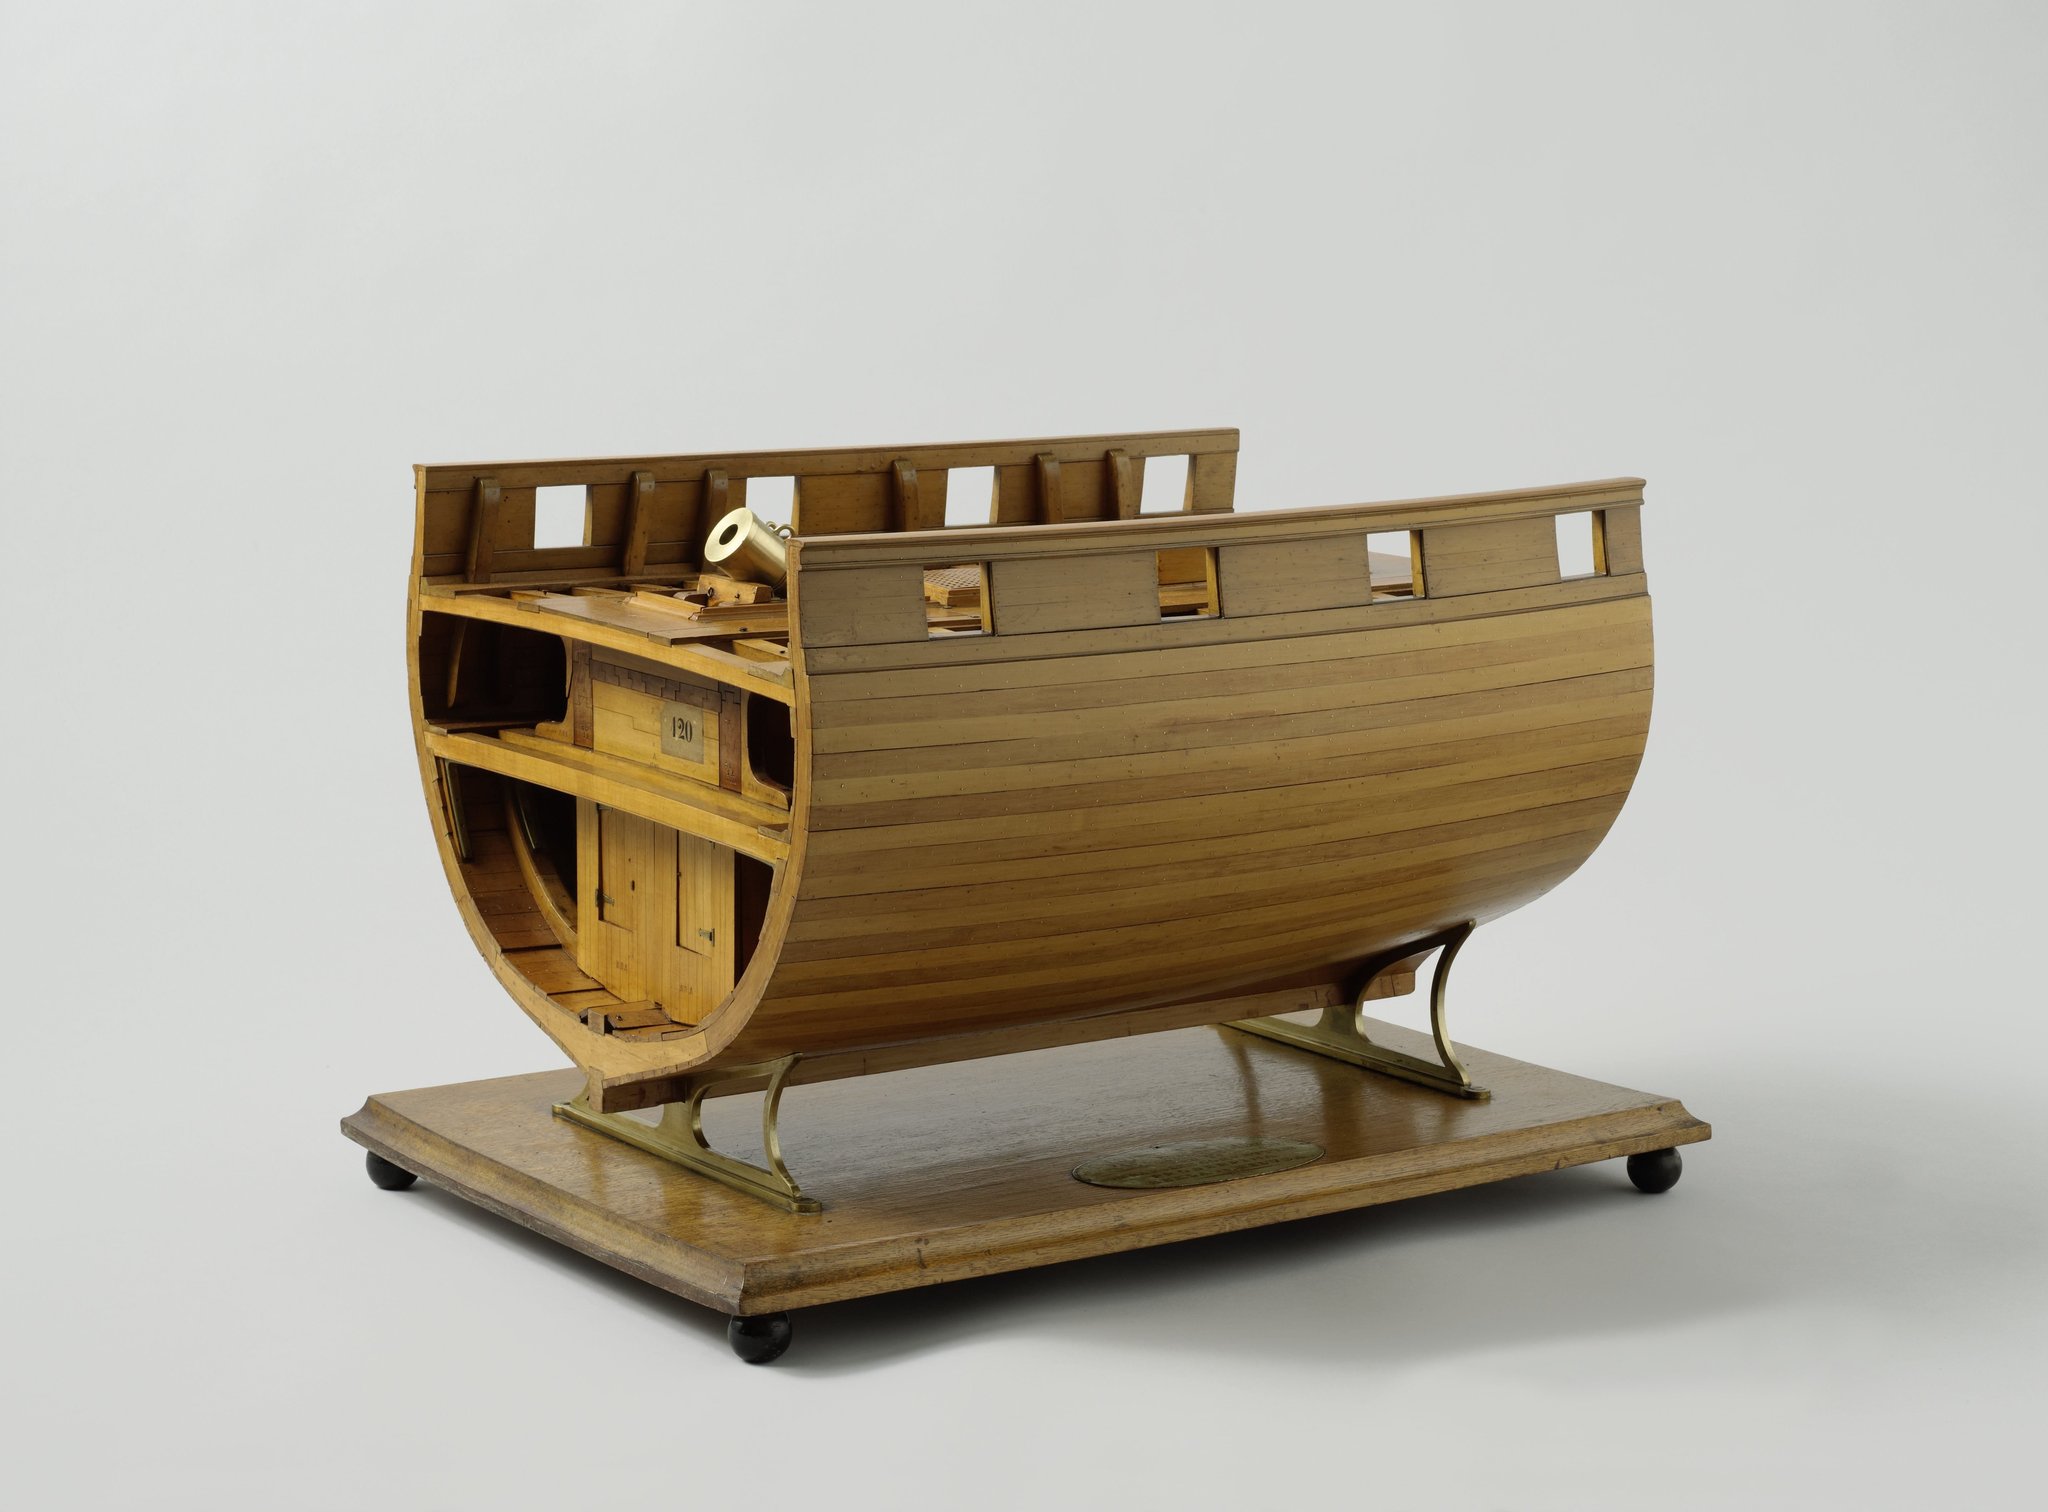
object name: demonstration model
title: Model of the Mortar Bed of a Bomb Sloop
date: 1842-1847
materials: brass, iron, wood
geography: rotterdam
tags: proserpina (schip), medusa (schip), hekla (schip)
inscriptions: label, on the wall: ‘120’ former inventory label, inscription, on the base: ‘Mortier Stelling / van de / BOMBARDEER CORVETTEN / PROSERPINA / HEKLA EN MEDUSA’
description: Model van de dwarsdoorsnede van een schip, waarop tweemaal de constructie van de ondersteuning van een mortierstelling is aangegeven, op standaard op grondplank. Aan één kant is de constructie geheel uitgewerkt en kan geheel uit elkaar genomen worden, aan de andere is zij slechts ten dele weergegeven. Het schip heeft twee dekken; onder iedere mortierstelling zijn in het ruim vijf kattesporen aangebracht, gaande van de ene kant naar de andere onder de dekbalken van het onderste dek. Tussendeks zijn in lengterichting twee wanden aangebracht van opeengestapelde balken, verbonden door zwaluwstaarten, die het bovendek ondersteunen. Het uitgewerkte deel is verder geheel volgebouwd met balken en stutten, waardoor in het ruim twee kasten ontstaan, het geheel afgewerkt met een groot aantal toegevoegde metalen en kunstknieën. Dit deel is ook gedetailleerd met de mortier op haar affuit à pivot. Delen van het dek moeten verwijderd worden om de pivot te laten draaien. Het mortier is 6.8 cm lang en heeft een 15 mm kaliber. Het andere, niet uitgewerkte gedeelte, is voorzien van de kap waarmee het geschut afgedekt wordt. Tussen beide mortierstellingen is een luik met roosters aangebracht. Het model heeft vier geschutpoorten aan iedere zijde aangebracht. Schaal 1:20 (volgens Obreen).